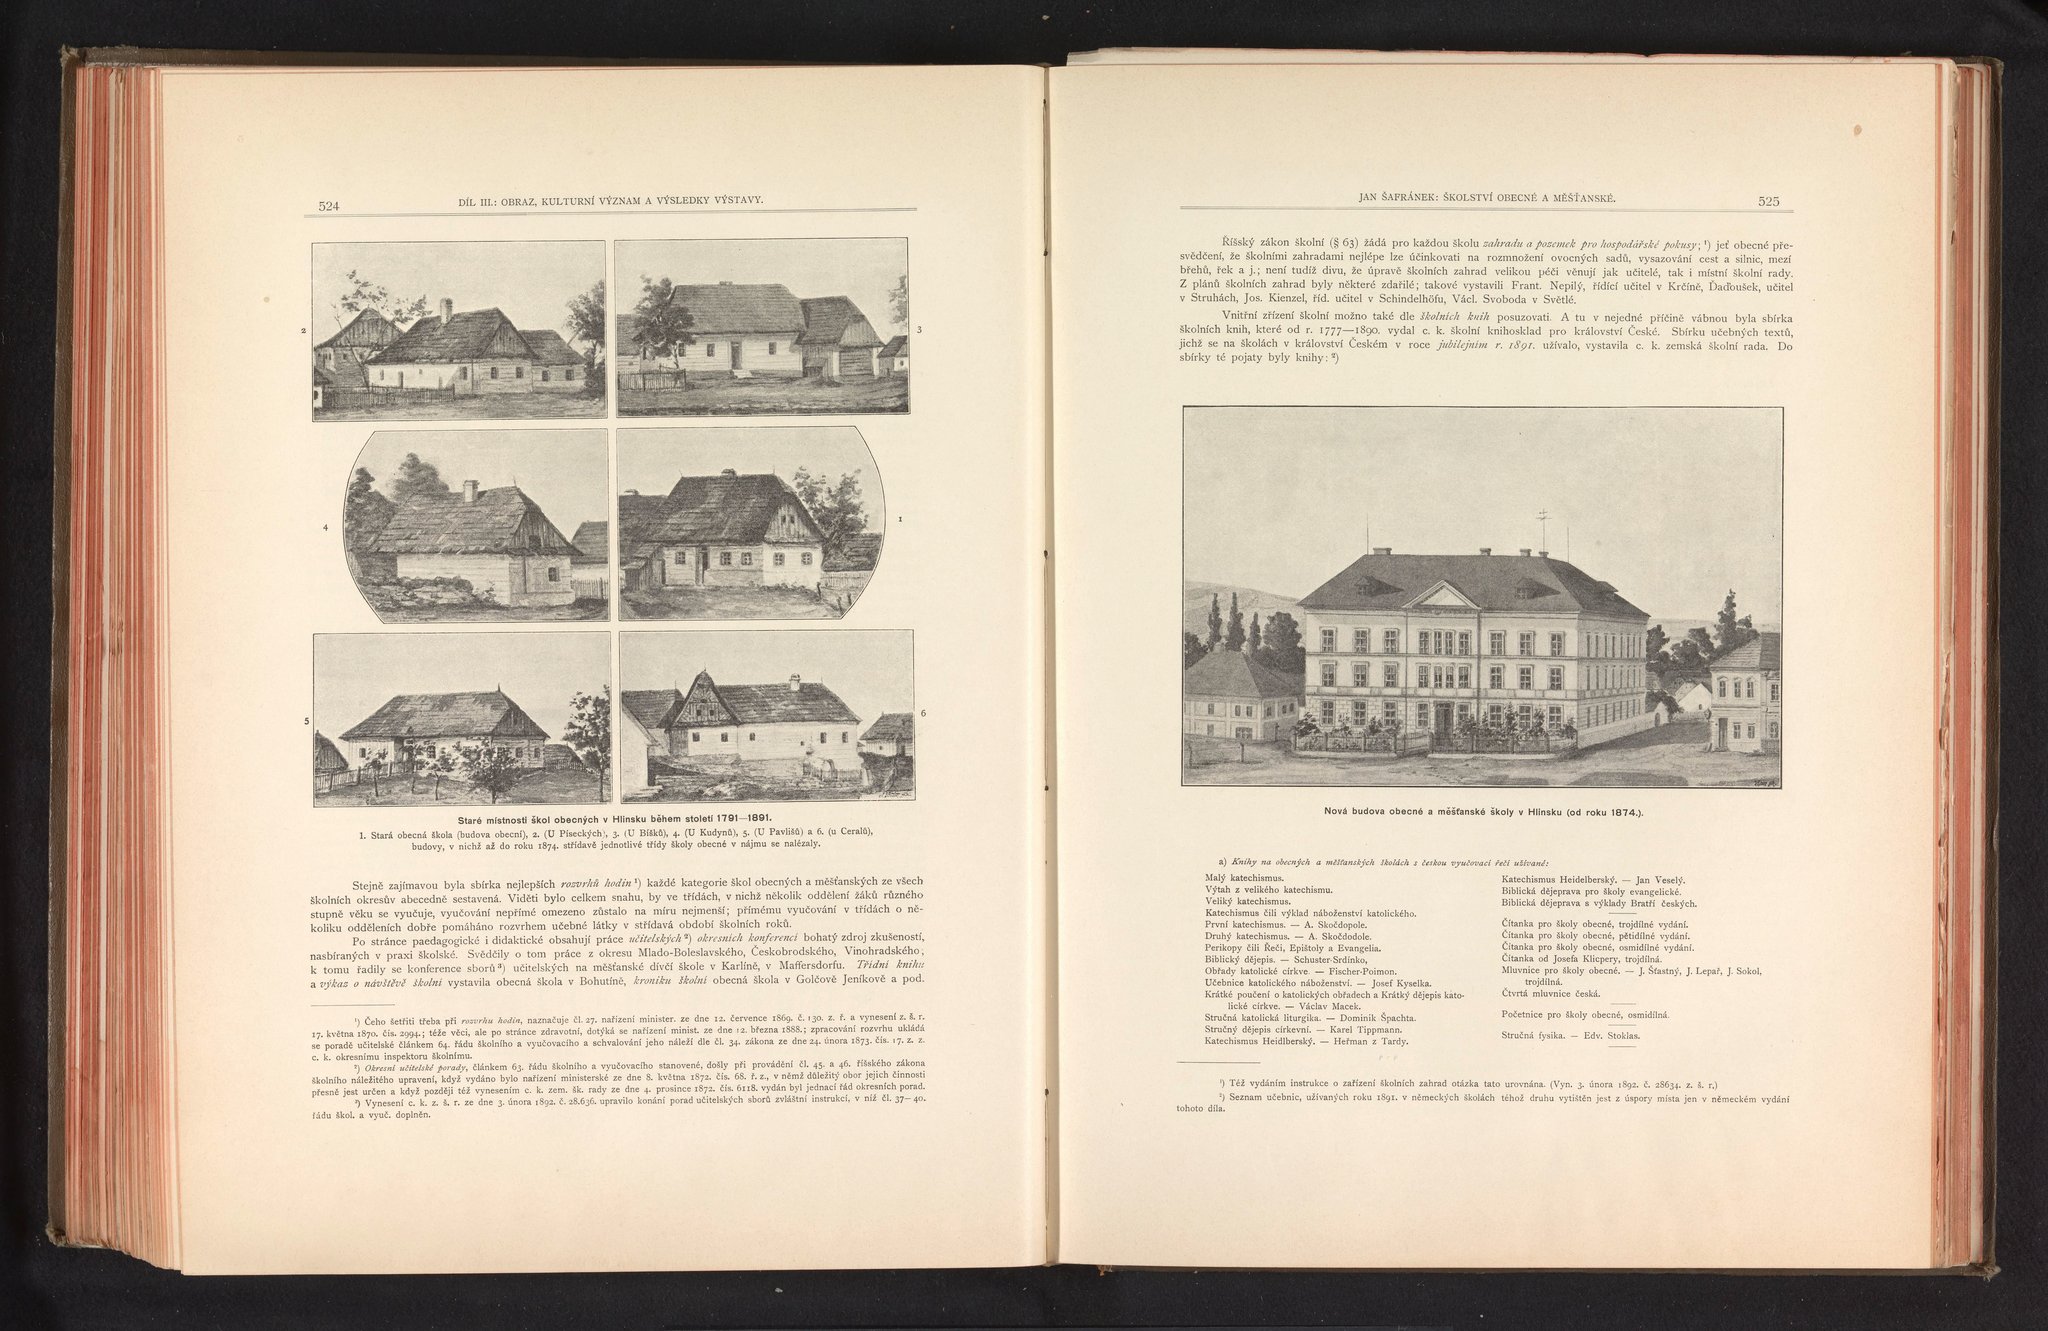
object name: reproduction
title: Fotoreproductie van een schilderij, voorstellende een exterieur van een school te Hlinsko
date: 1891-1895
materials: paper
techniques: autotype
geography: prague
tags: façade (of house or building), elementary school; class, form